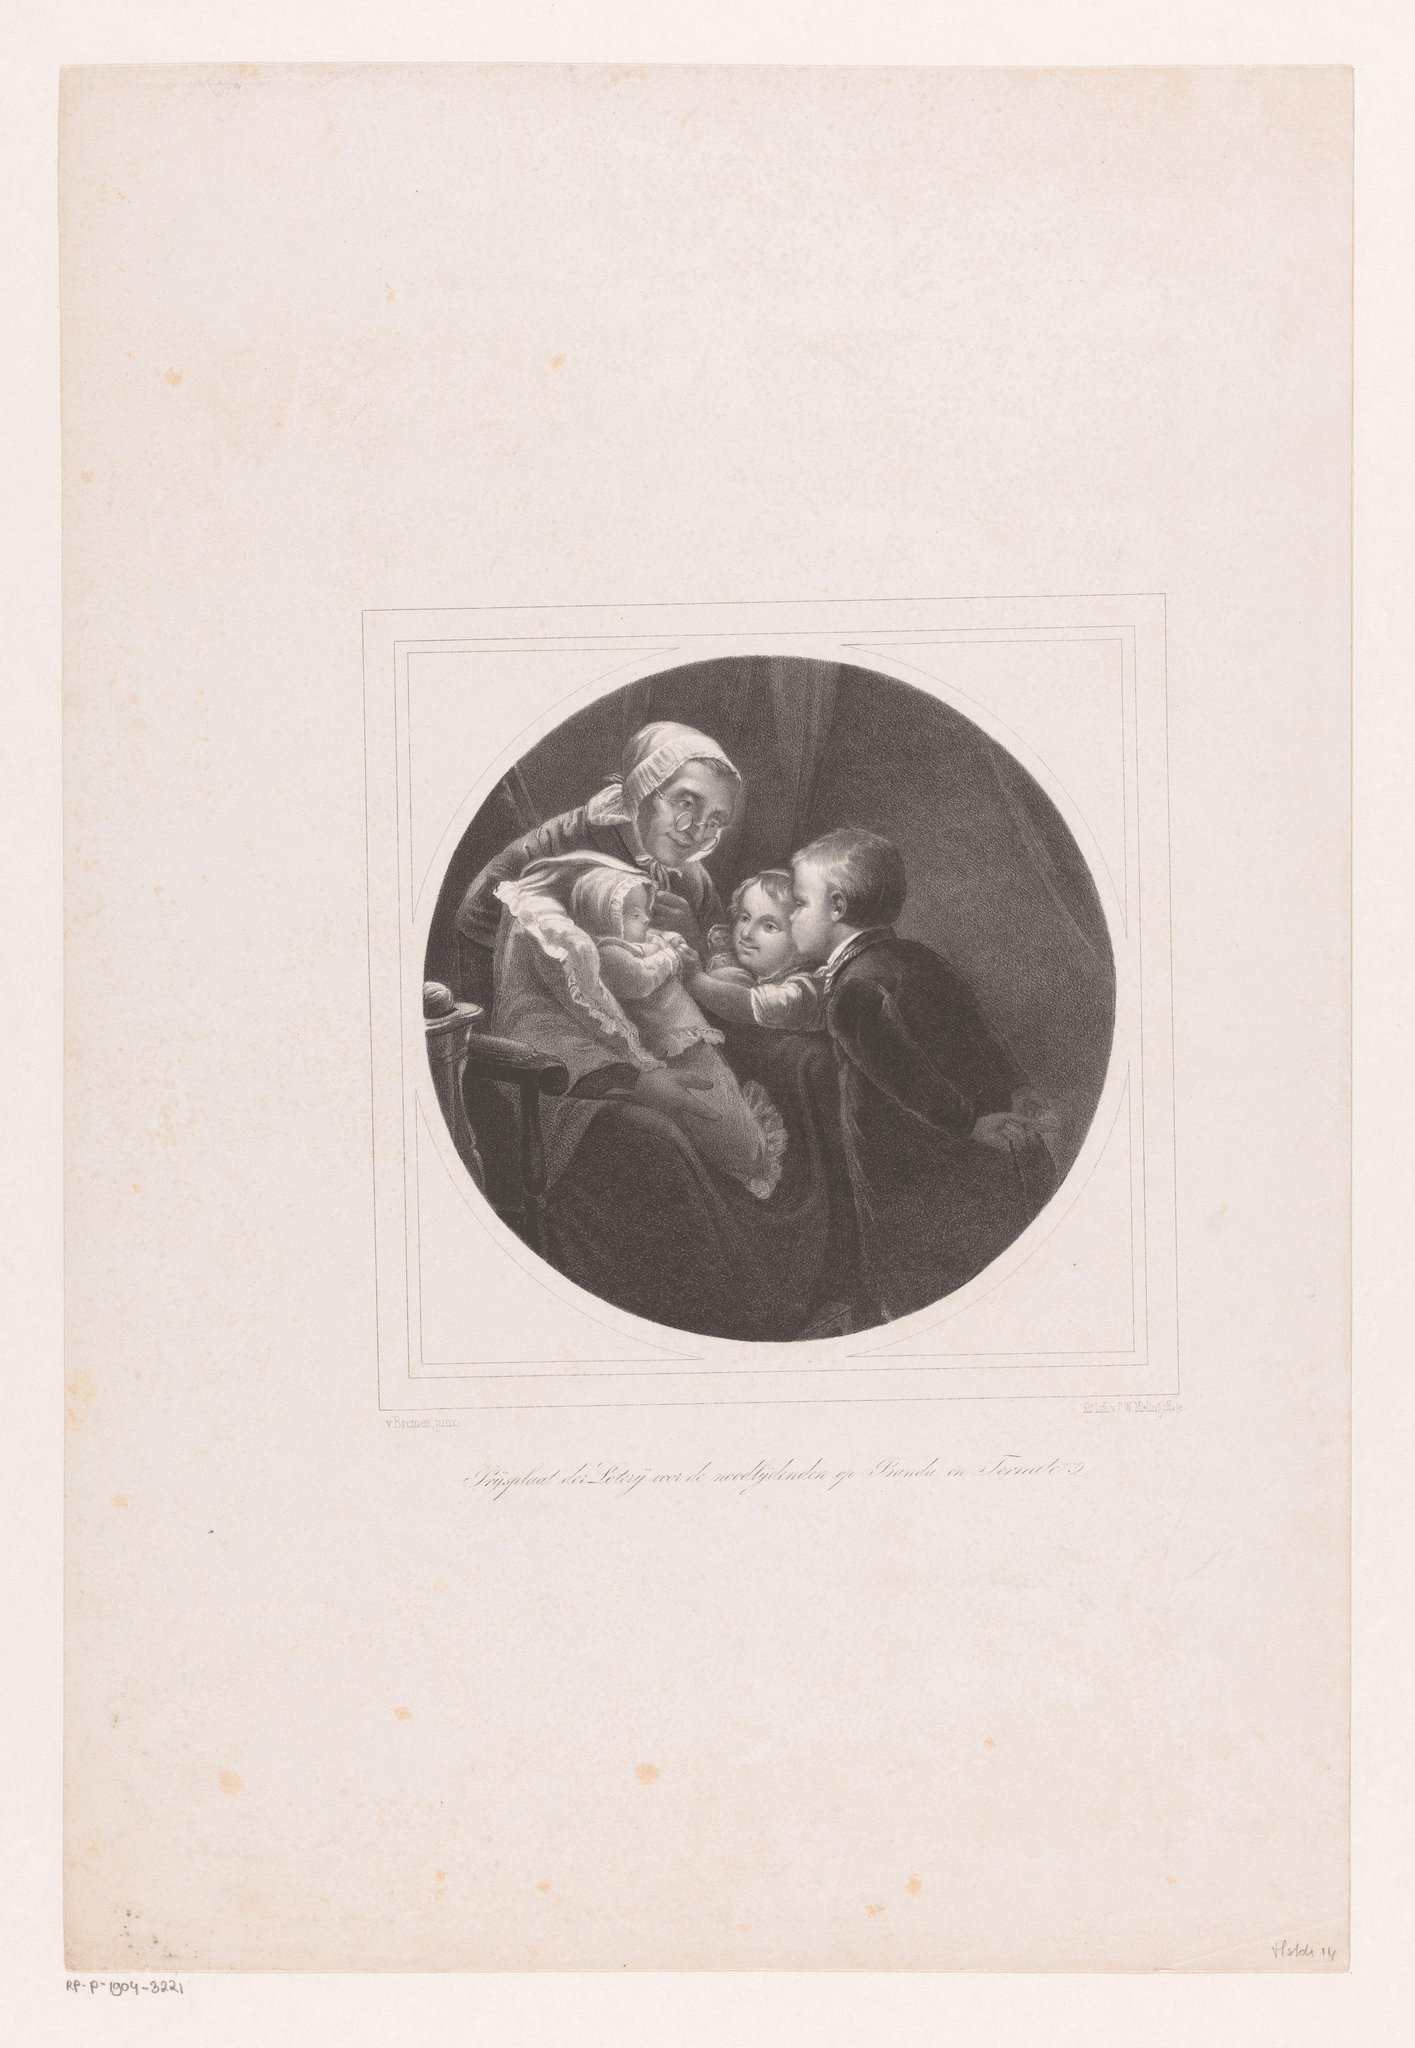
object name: print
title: Prijsplaat der loterij voor de noodlijdenden op Banda en Ternate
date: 1847-1865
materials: paper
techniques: lithograph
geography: the hague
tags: midwife, 'accoucheuse', dry-nurse, baby in swaddling clothes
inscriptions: collector's mark: Lugt 2228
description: De vroedvrouw of baker is op leeftijd en draagt een bril. Het meisje heeft een pop in haar handen, de jongen houdt zijn handen achter zijn rug.